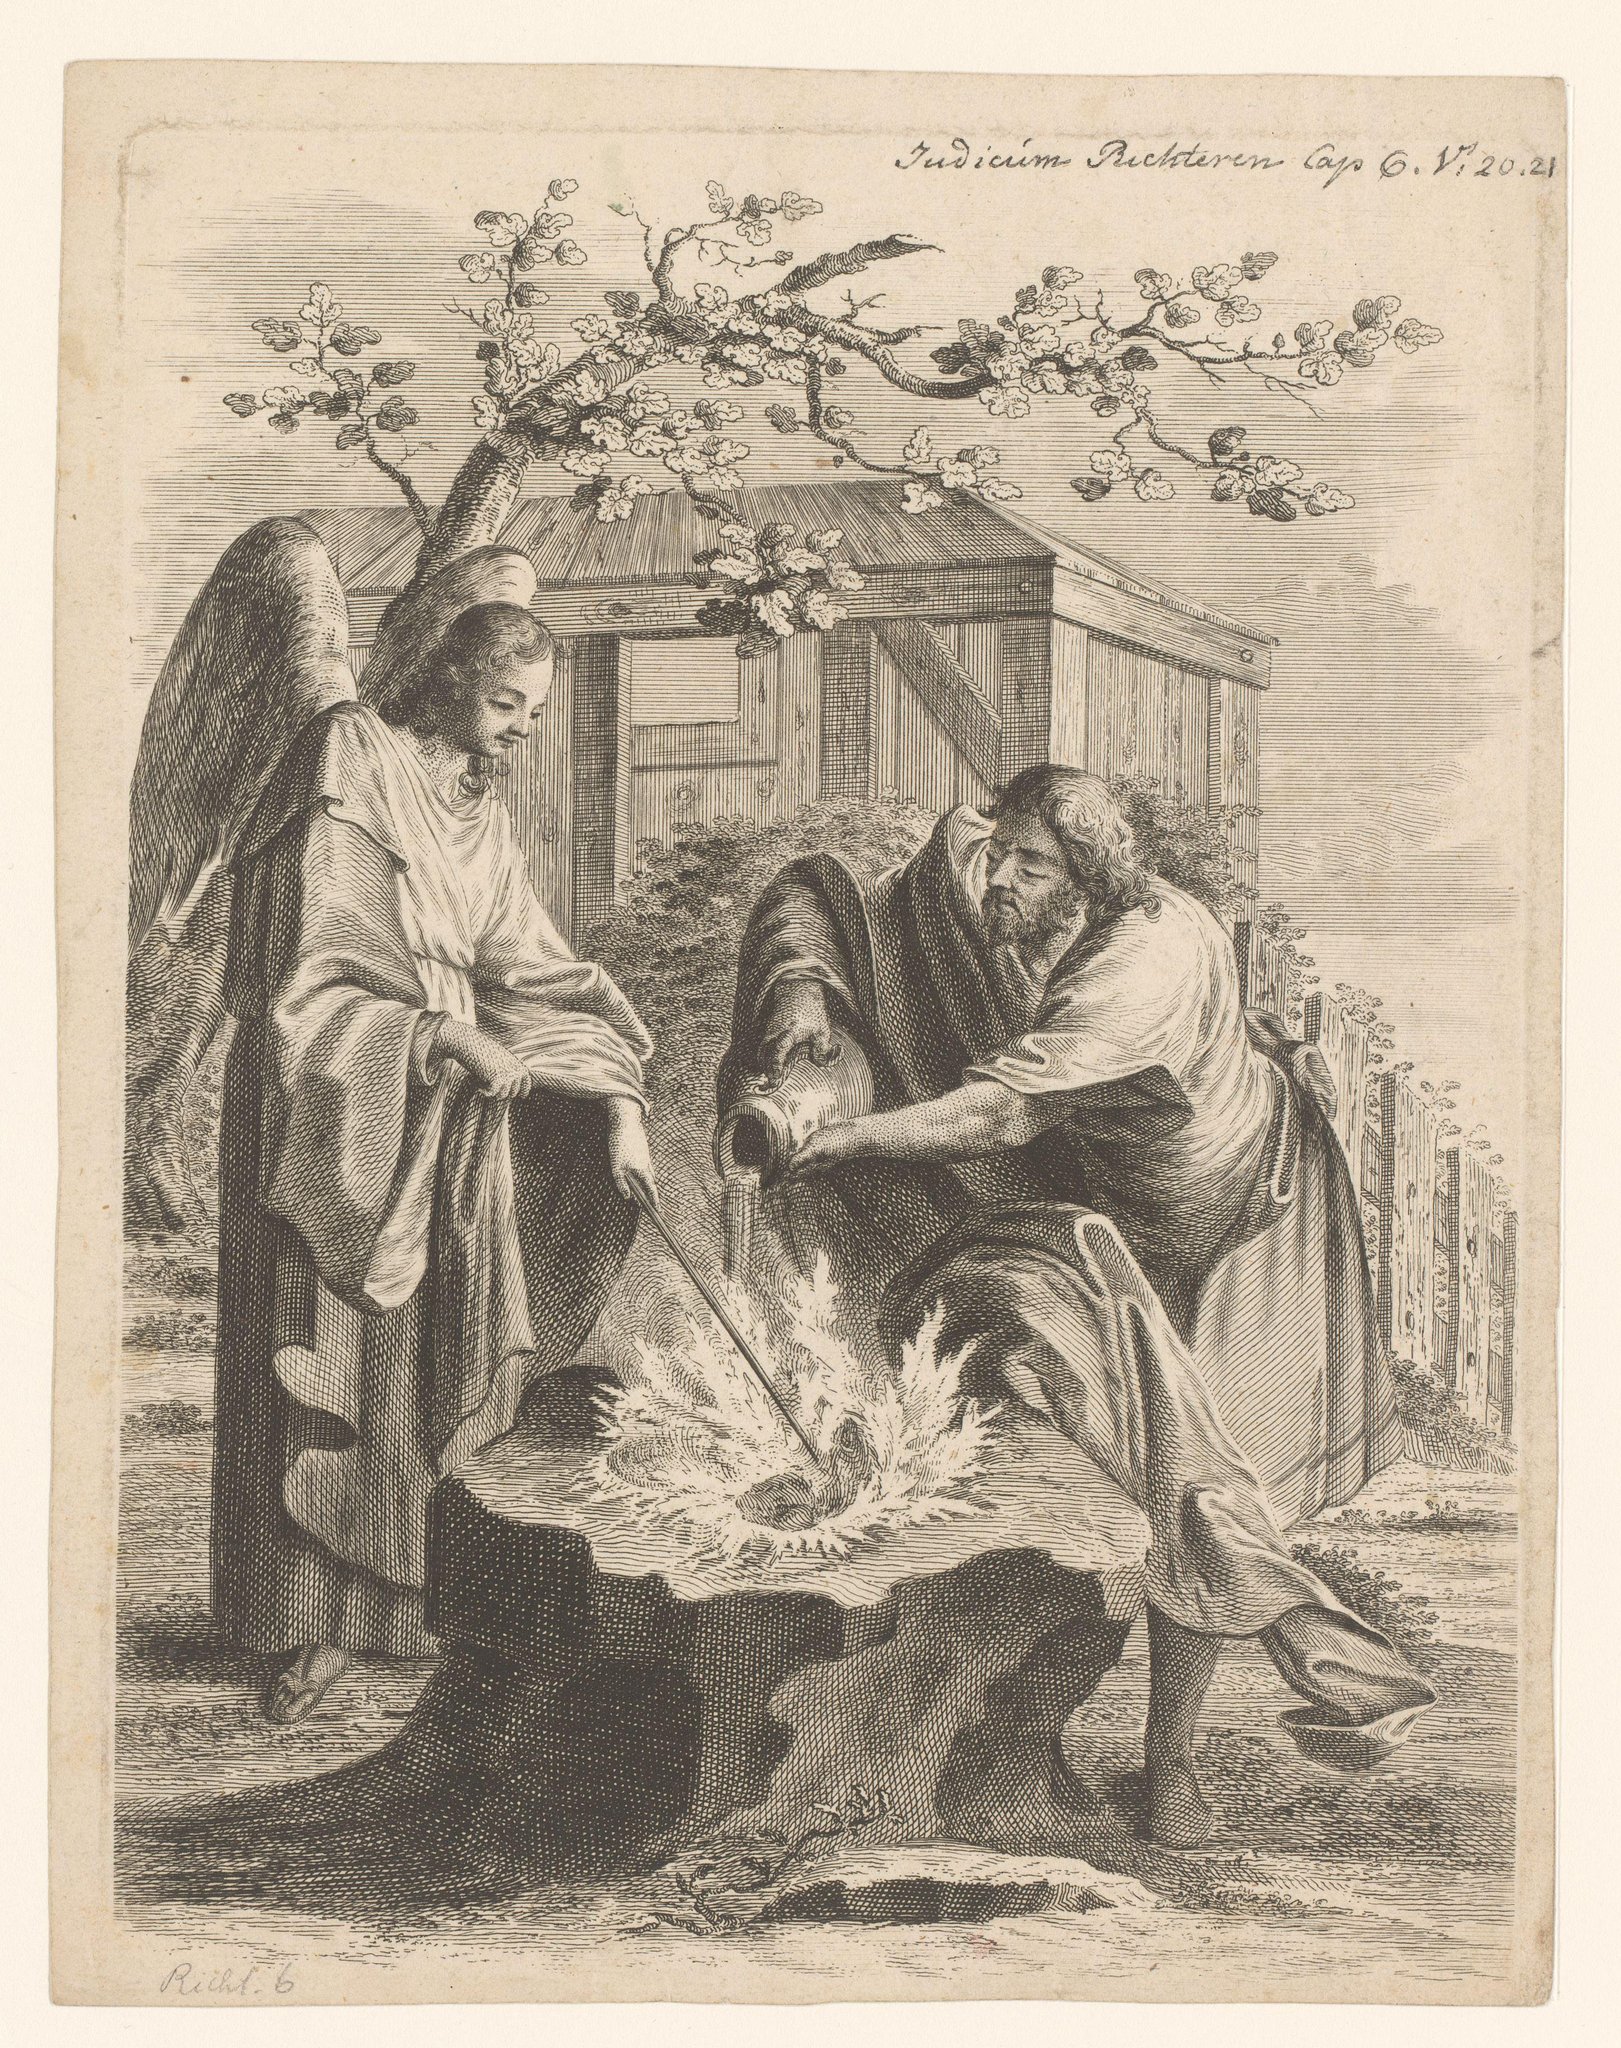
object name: print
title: Offer van Gideon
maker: Anonymous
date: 1700-1799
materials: paper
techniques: engraving, etching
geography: low countries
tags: the angel of the lord touches the food with his staff, fire arises from the rock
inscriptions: inscription: ‘Indicúm Richteren Cap 6. V:20.21’, collector's mark: Lugt 2228